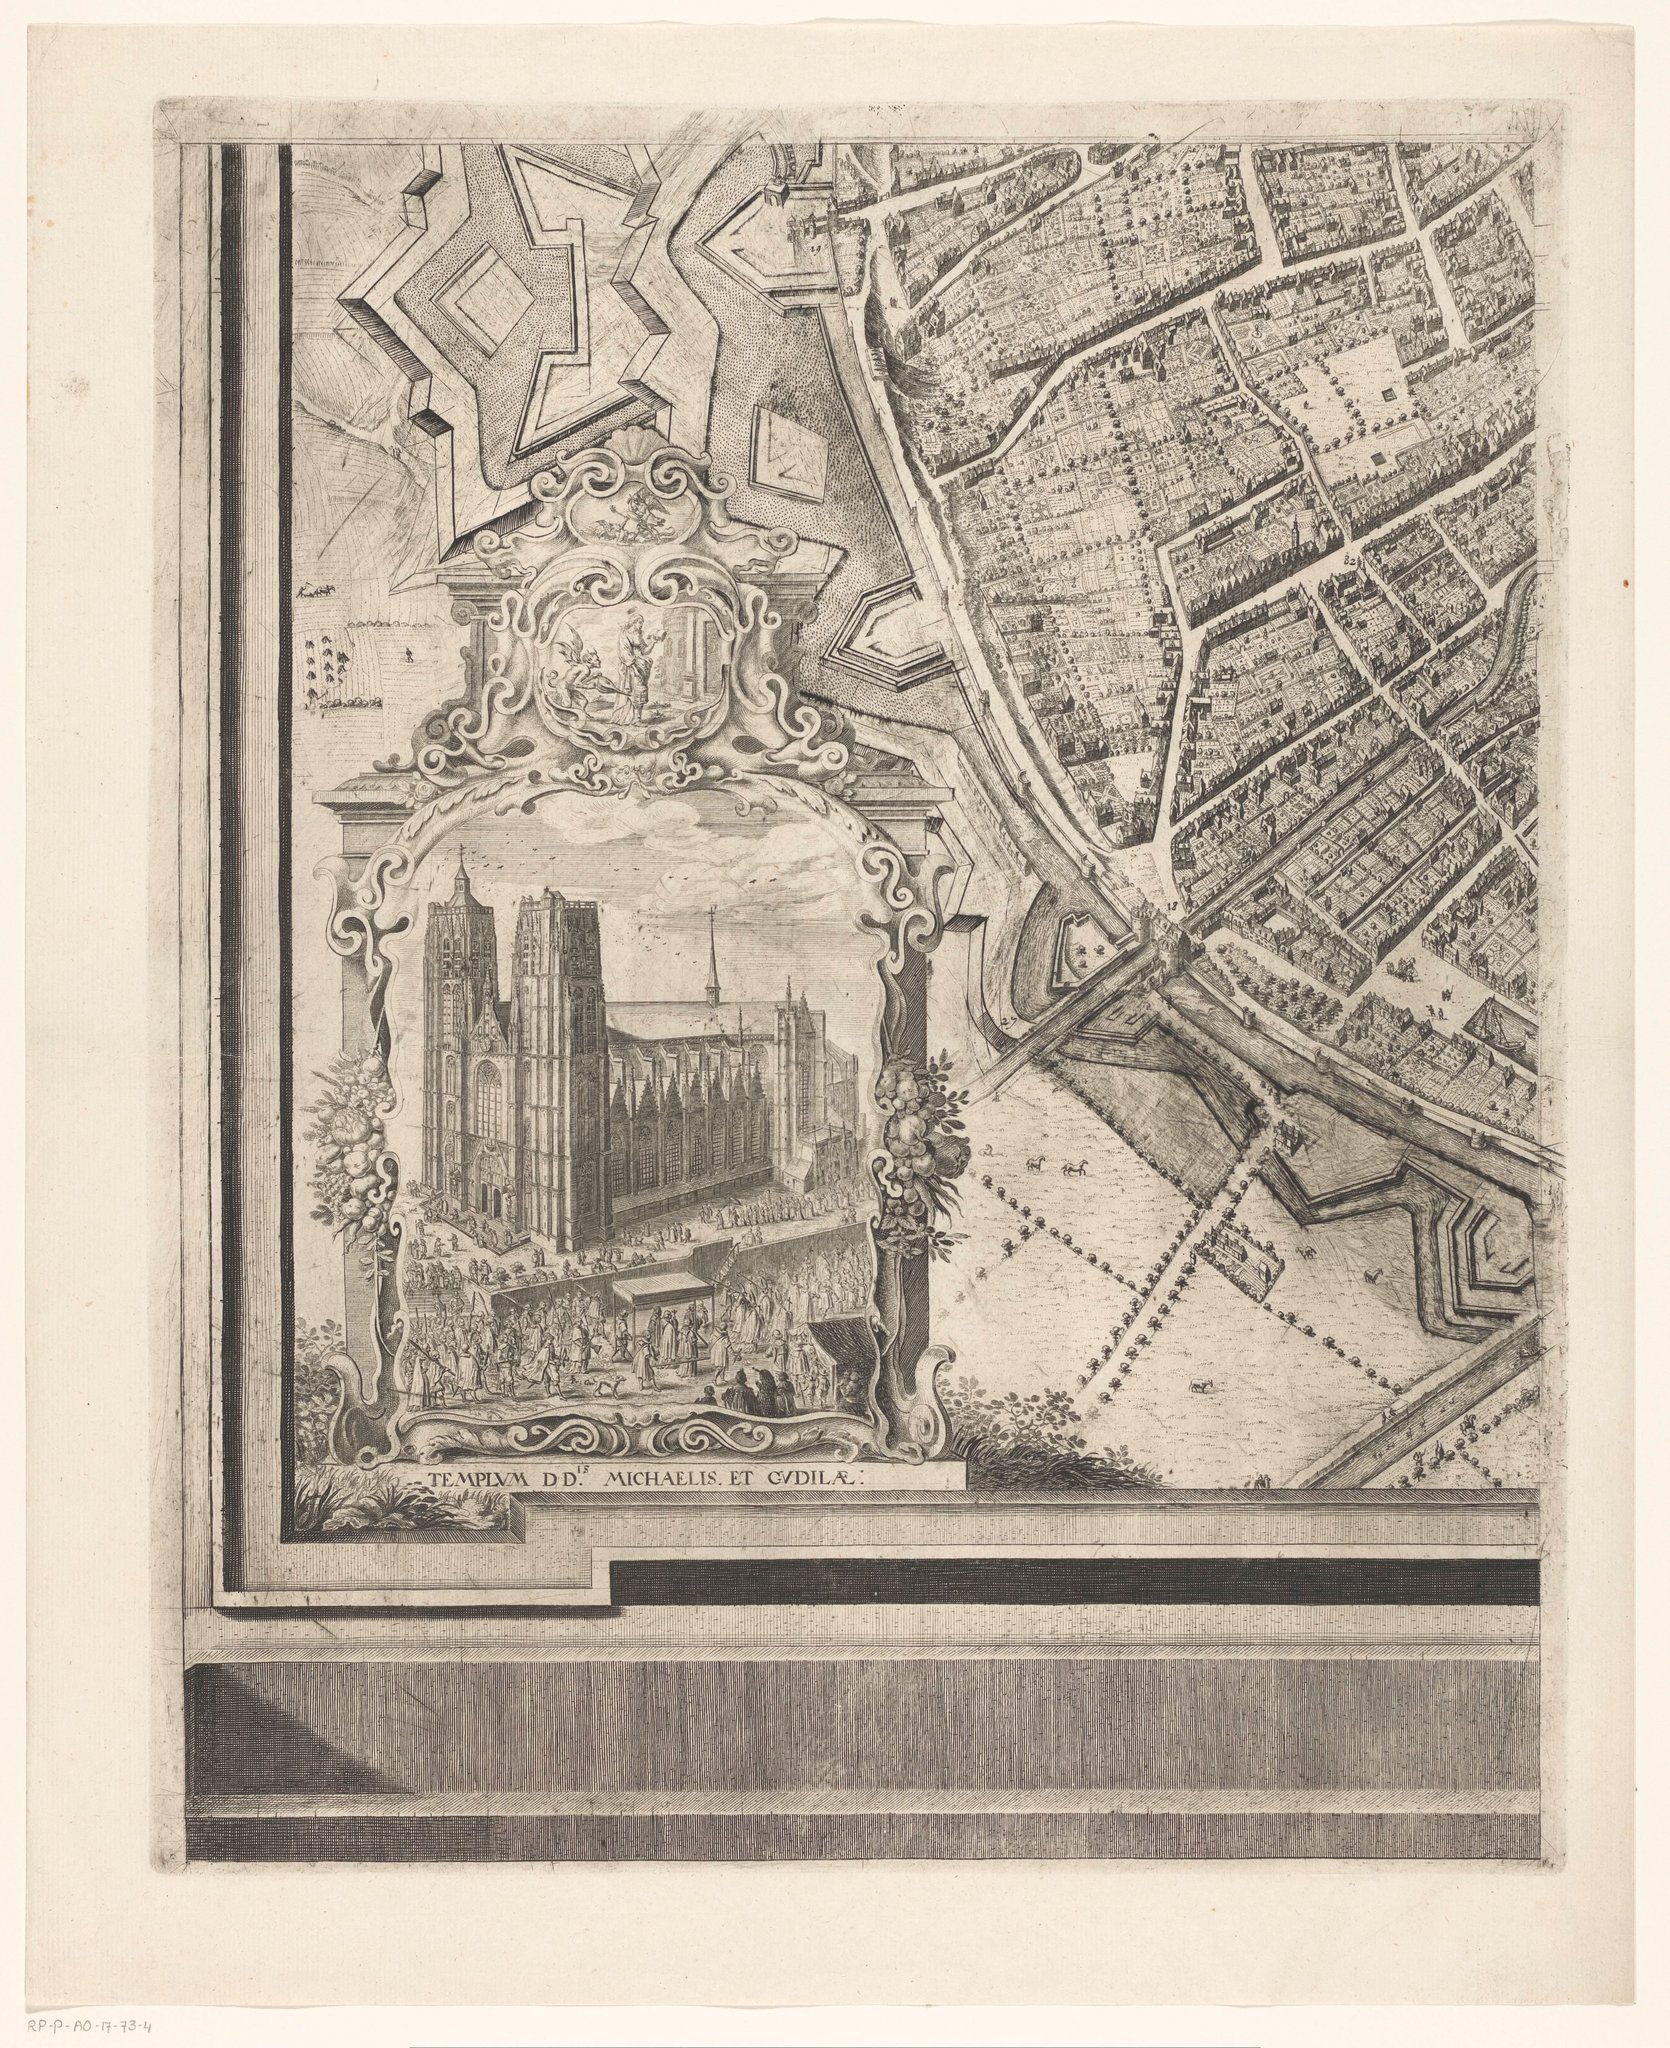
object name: area plan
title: Bruxella nobilissima Brabantiae civitas restauratum ano 1748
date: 1640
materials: paper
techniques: engraving, etching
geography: brussels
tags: filips iv (koning van spanje), the archangel michael fighting the dragon (devil, satan), church (exterior), fortified city, maps of cities, brussels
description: Onderdeel van de plattegrond van de tweede uitgave (1748) van een wandkaart van Brussel, getiteld 'Bruxella nobilissima Brabantiae civitas restauratum ano 1748'. Deze wandkaart bestond uit deze plattegrond (gedrukt van zes platen, zie: RP-P-AO-17-73) met daaronder of daarboven een stadsgezicht (gedrukt van drie platen, zie: RP-P-AO-17-74), met langs de zijkanten een beschrijving van de stad en gezichten op gebouwen. De eerste uitgave verscheen in 1640 onder de titel 'Bruxella nobilissima Brabantiae civitas ano 1640'.